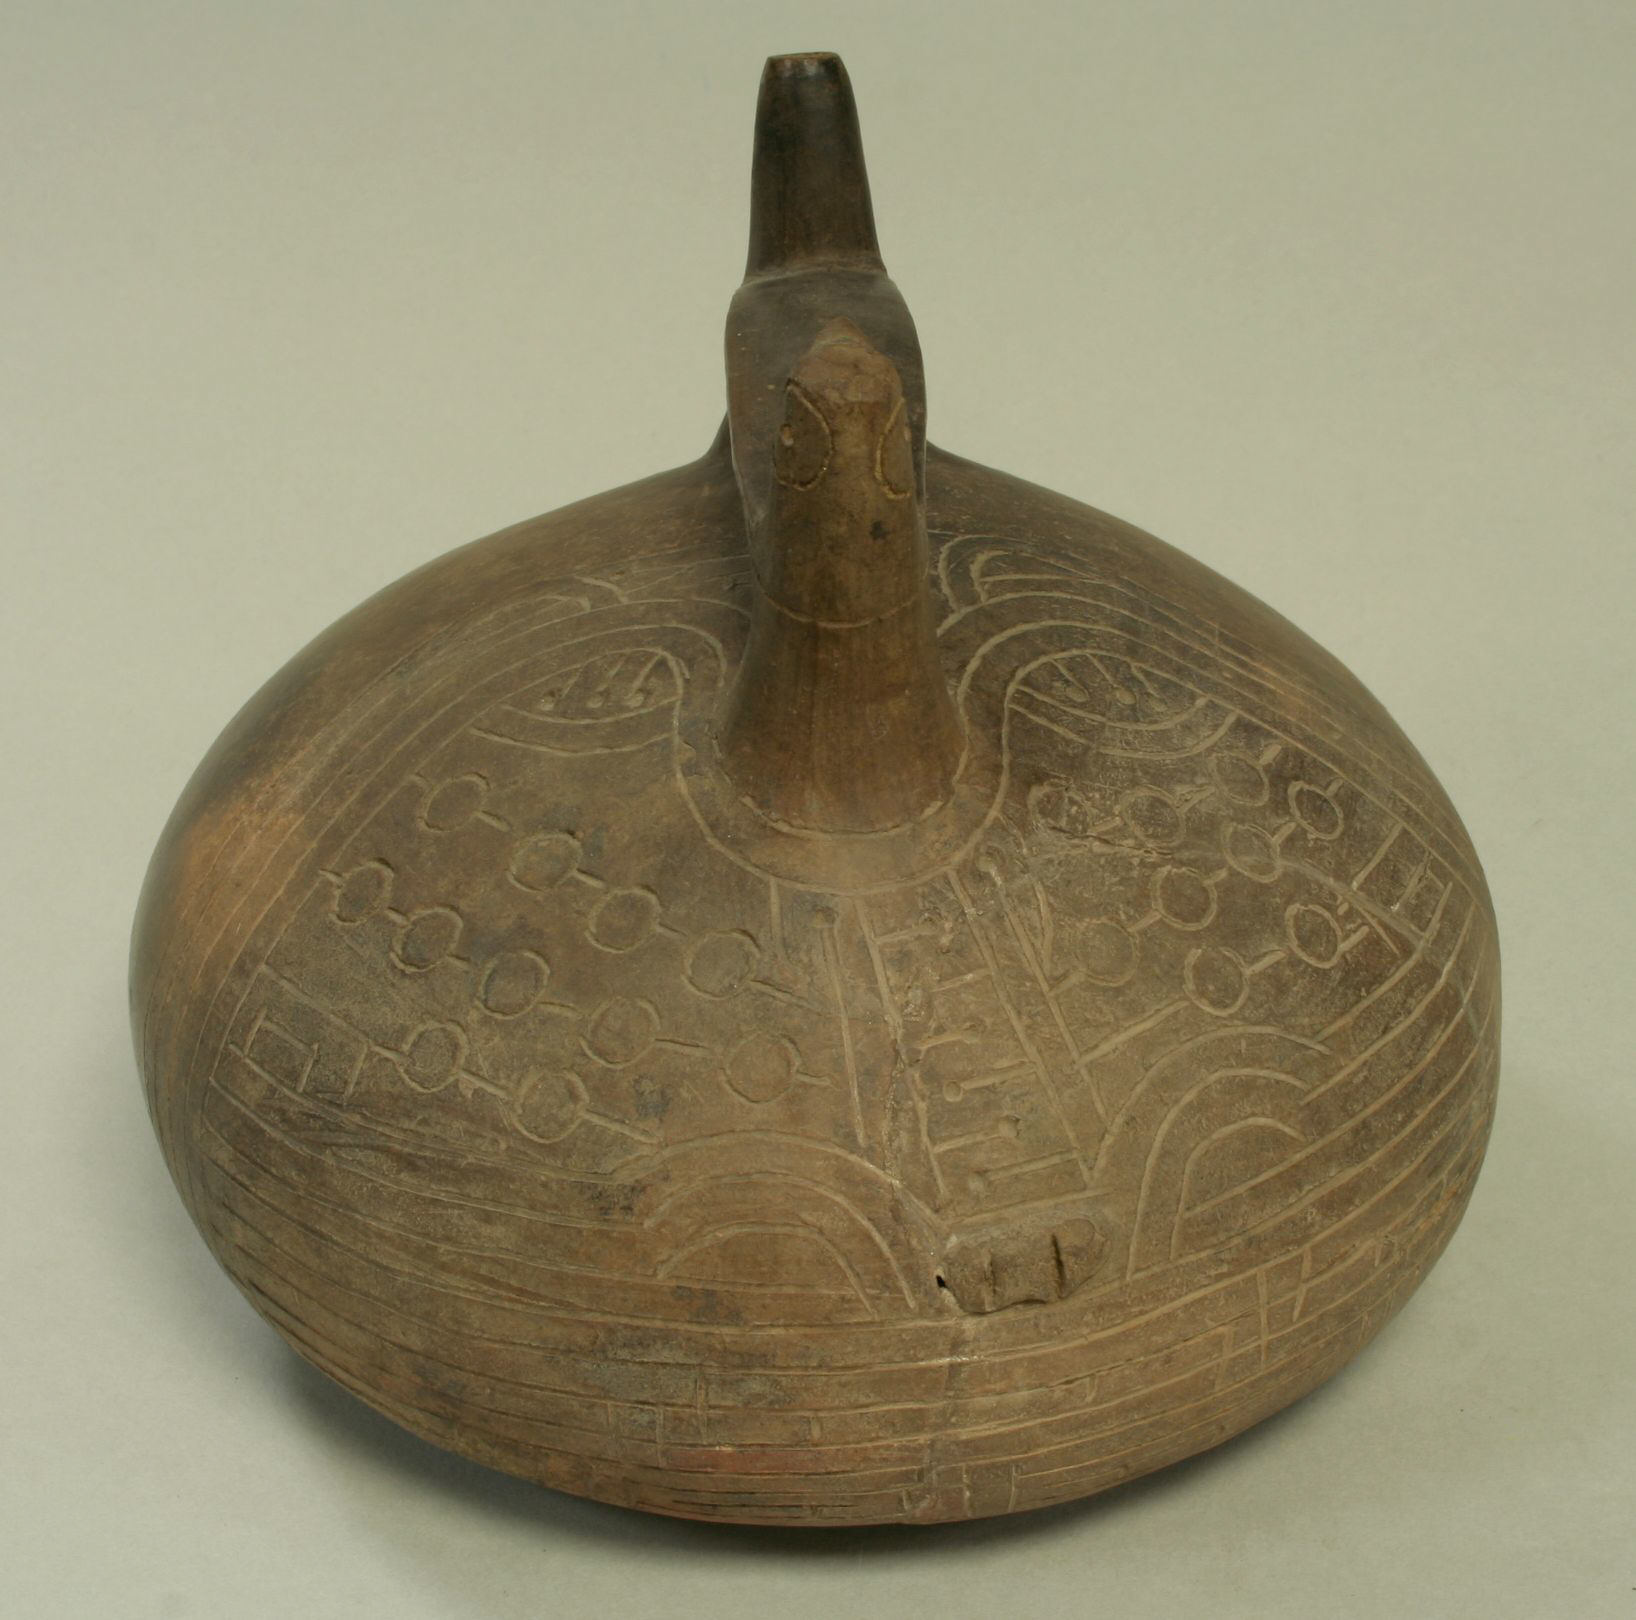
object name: bottle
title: Bottle, Feline Face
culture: paracas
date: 500-101 BCE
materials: ceramic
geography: peru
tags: cats